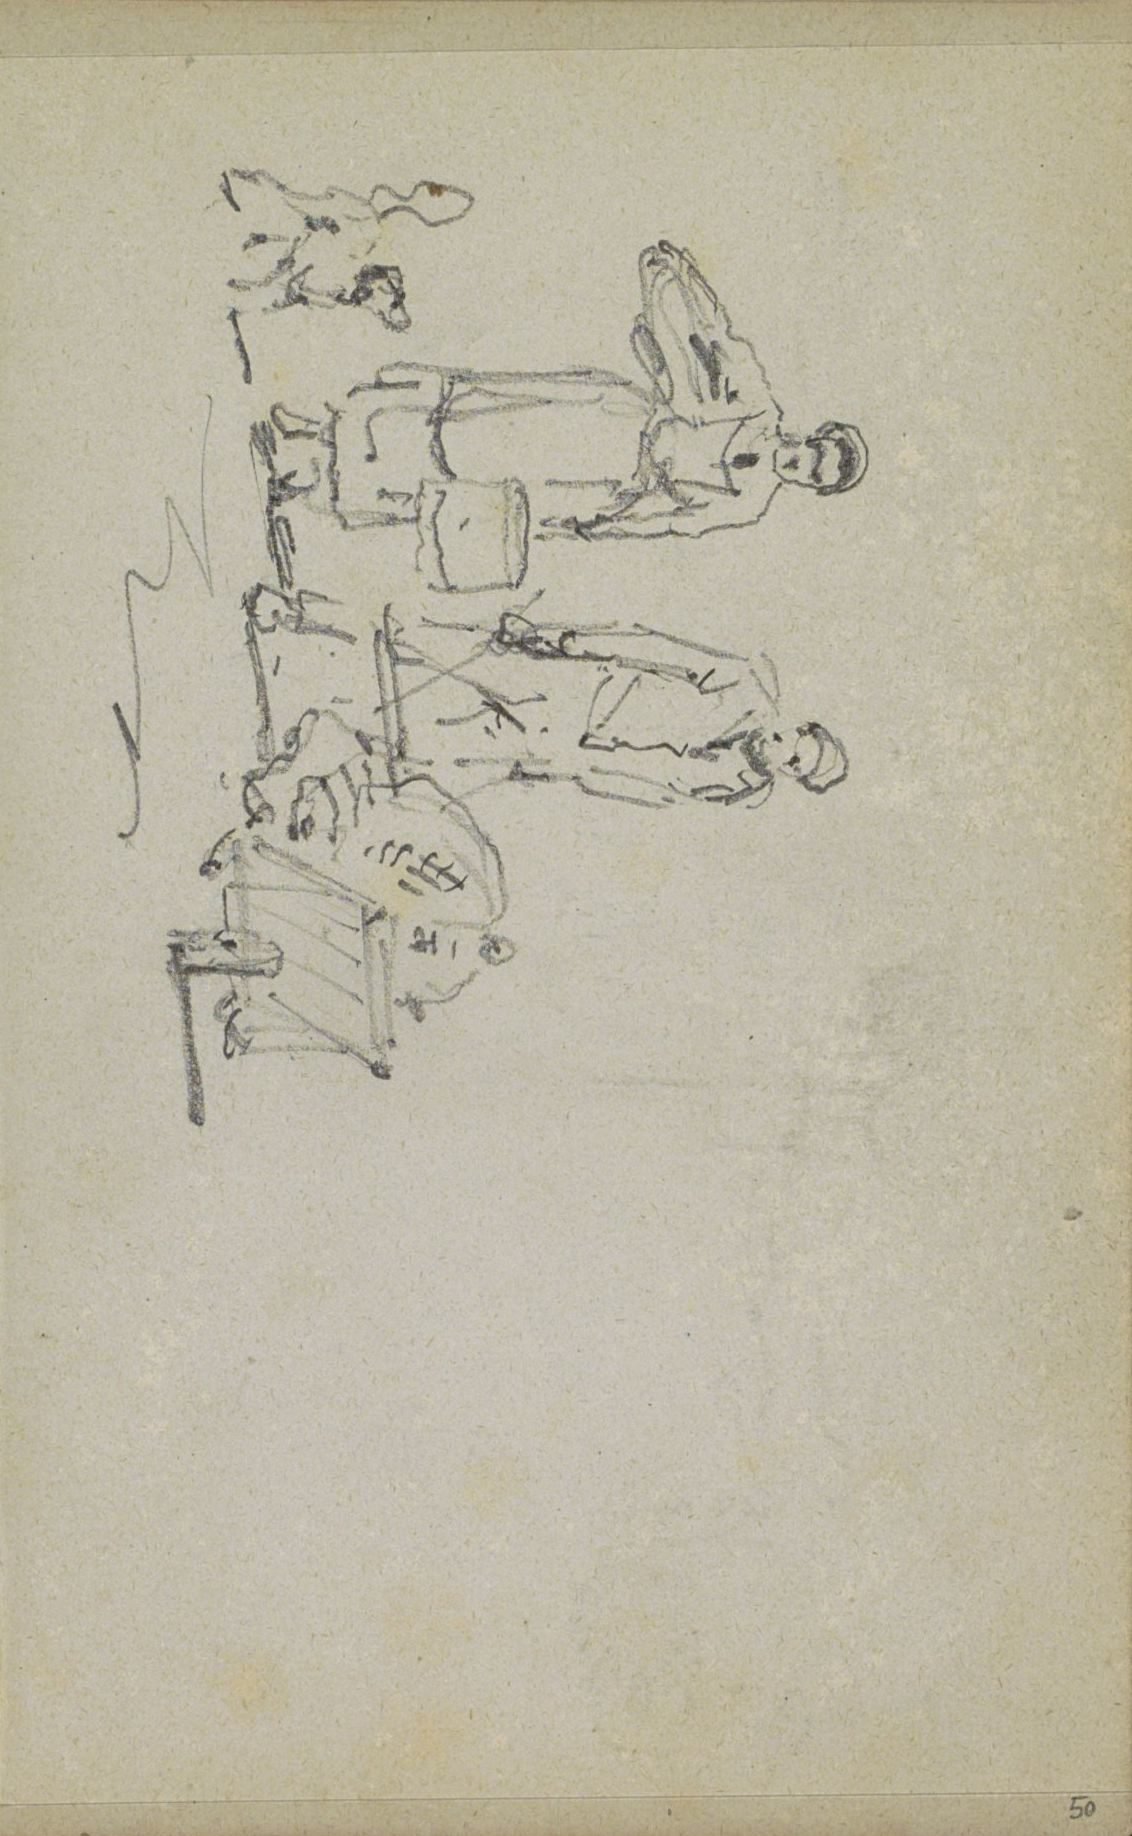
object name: sketchbook leaf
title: Sjouwende figuren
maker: adrianus eversen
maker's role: draughtsman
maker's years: 1818-1897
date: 1828-1897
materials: paper, pencil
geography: netherlands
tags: adult woman, carrying something, adult man, dog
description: Links een hond naast een vrouw met spullen onder haar arm en in haar hand. Rechts een man achter een handkar met zakken. Blad 50 recto uit een schetsboek met 58 bladen.